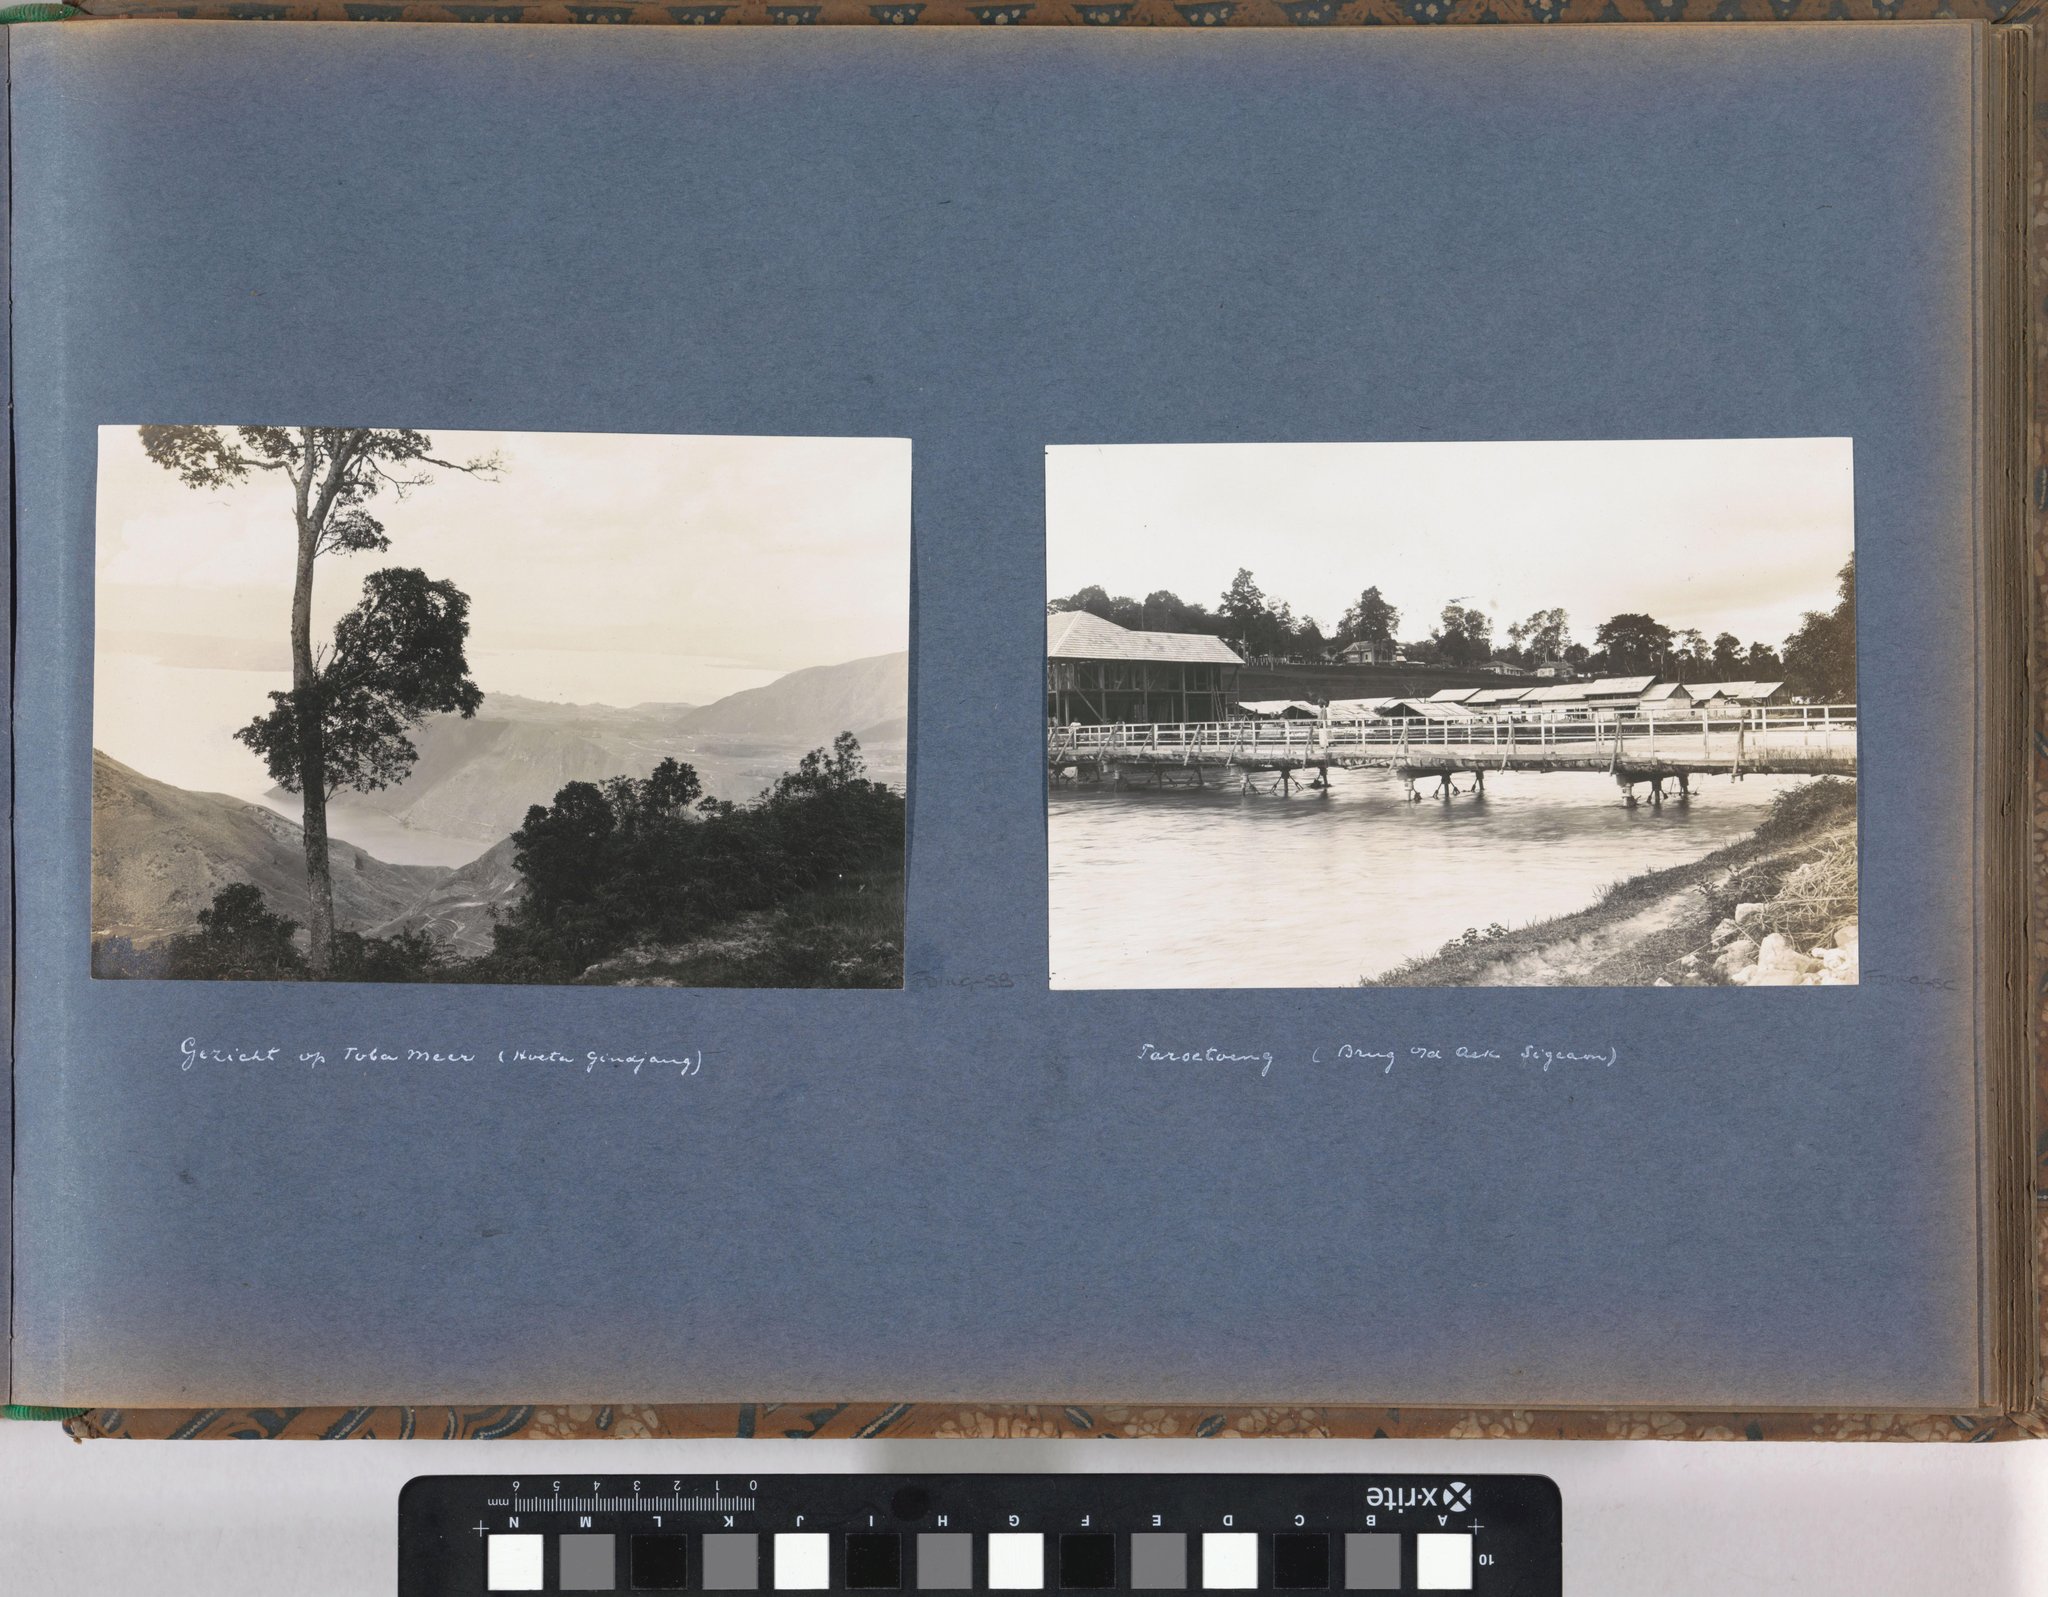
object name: photograph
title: Brug over een rivier te Taroetoeng op Sumatra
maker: Anonymous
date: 1900-1920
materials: paper, photographic support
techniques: gelatin silver print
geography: sumatra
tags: bridge in city across river, canal, etc., sumatra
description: Onderdeel van reisalbum met foto's van bedrijvigheid en bezienswaardigheden op Sumatra en Java en van de reis naar en van Nederlands-Indië.